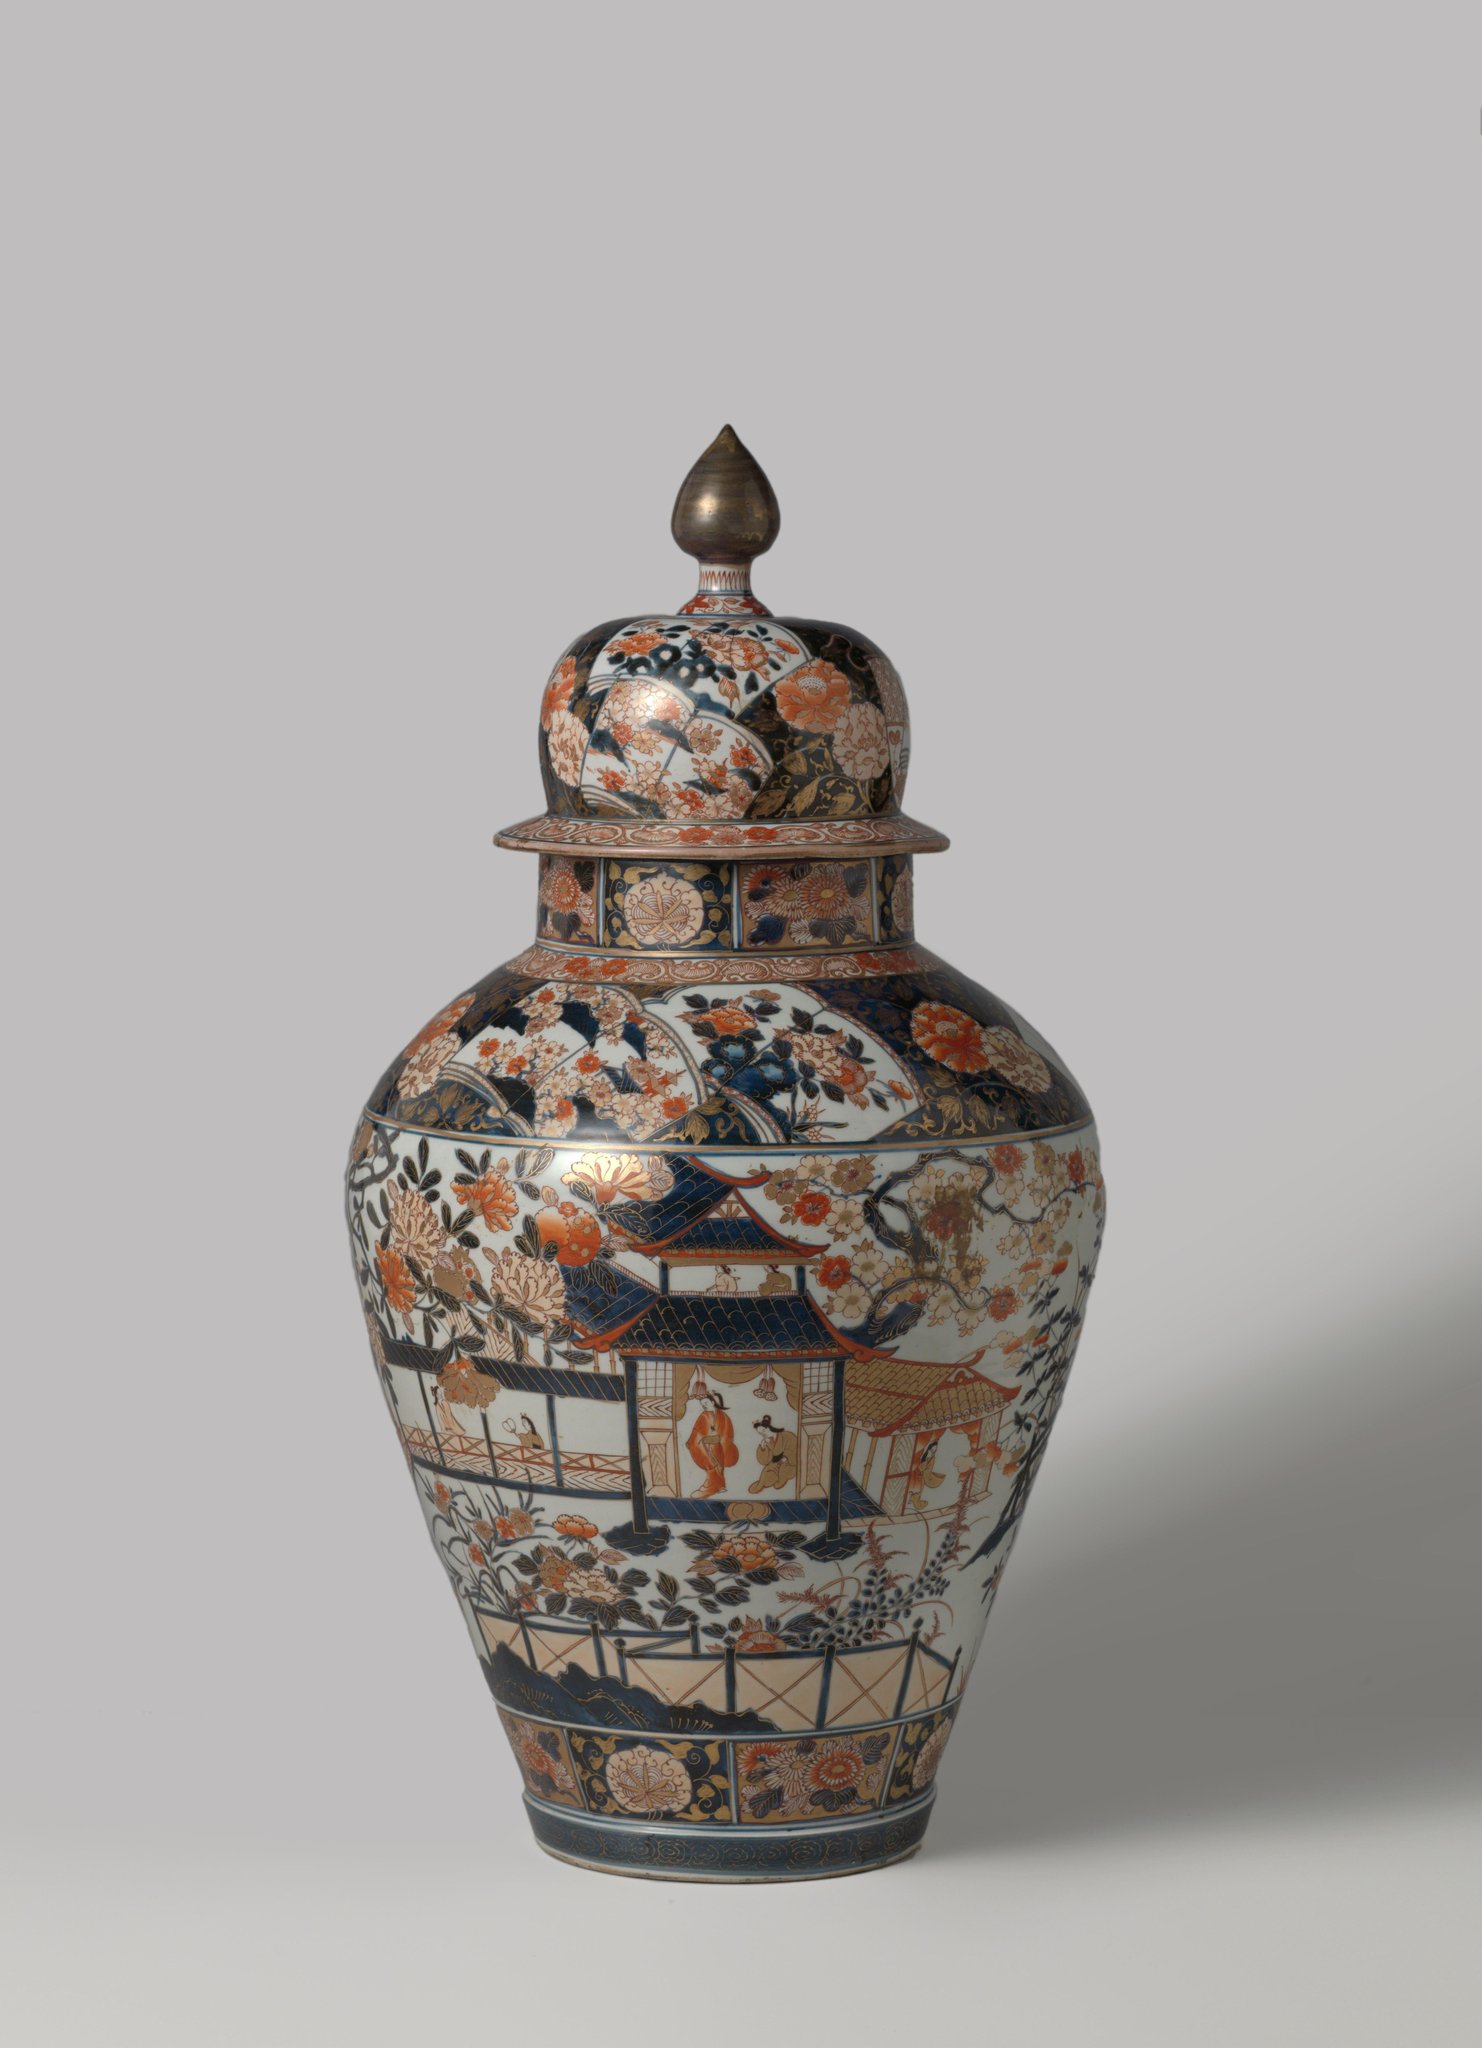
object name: covered jar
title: Ovoid covered jar with women in pavillions among flowering plants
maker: Anonymous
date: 1700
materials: cobalt, glaze, gold, paint, porcelain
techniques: firing, forming, gilding, turning, vitrification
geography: japan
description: Eivormige dekselpot van porselein, beschilderd in onderglazuur blauw en op het glazuur rood, zwart en goud. Op de buik een doorlopende voorstelling van verschillende paviljoens met vrouwen omringd door een rots en grote bloeiende planten (pioen, anjer, prunus, chrysant) in een omheinde tuin. Op de schouder een brede band met pioenranken onderbroken door boekvormige cartouches met landschappen of bloeiende planten. Rond de hals een band met bladranken onderbroken door groepjes van drie prunusbloemen. Rond de voet en op de hals een band met afwisselend een gestileerde bloemrank en chrysanten in vakken. De voet met een band met een wolkmotief. Imari.